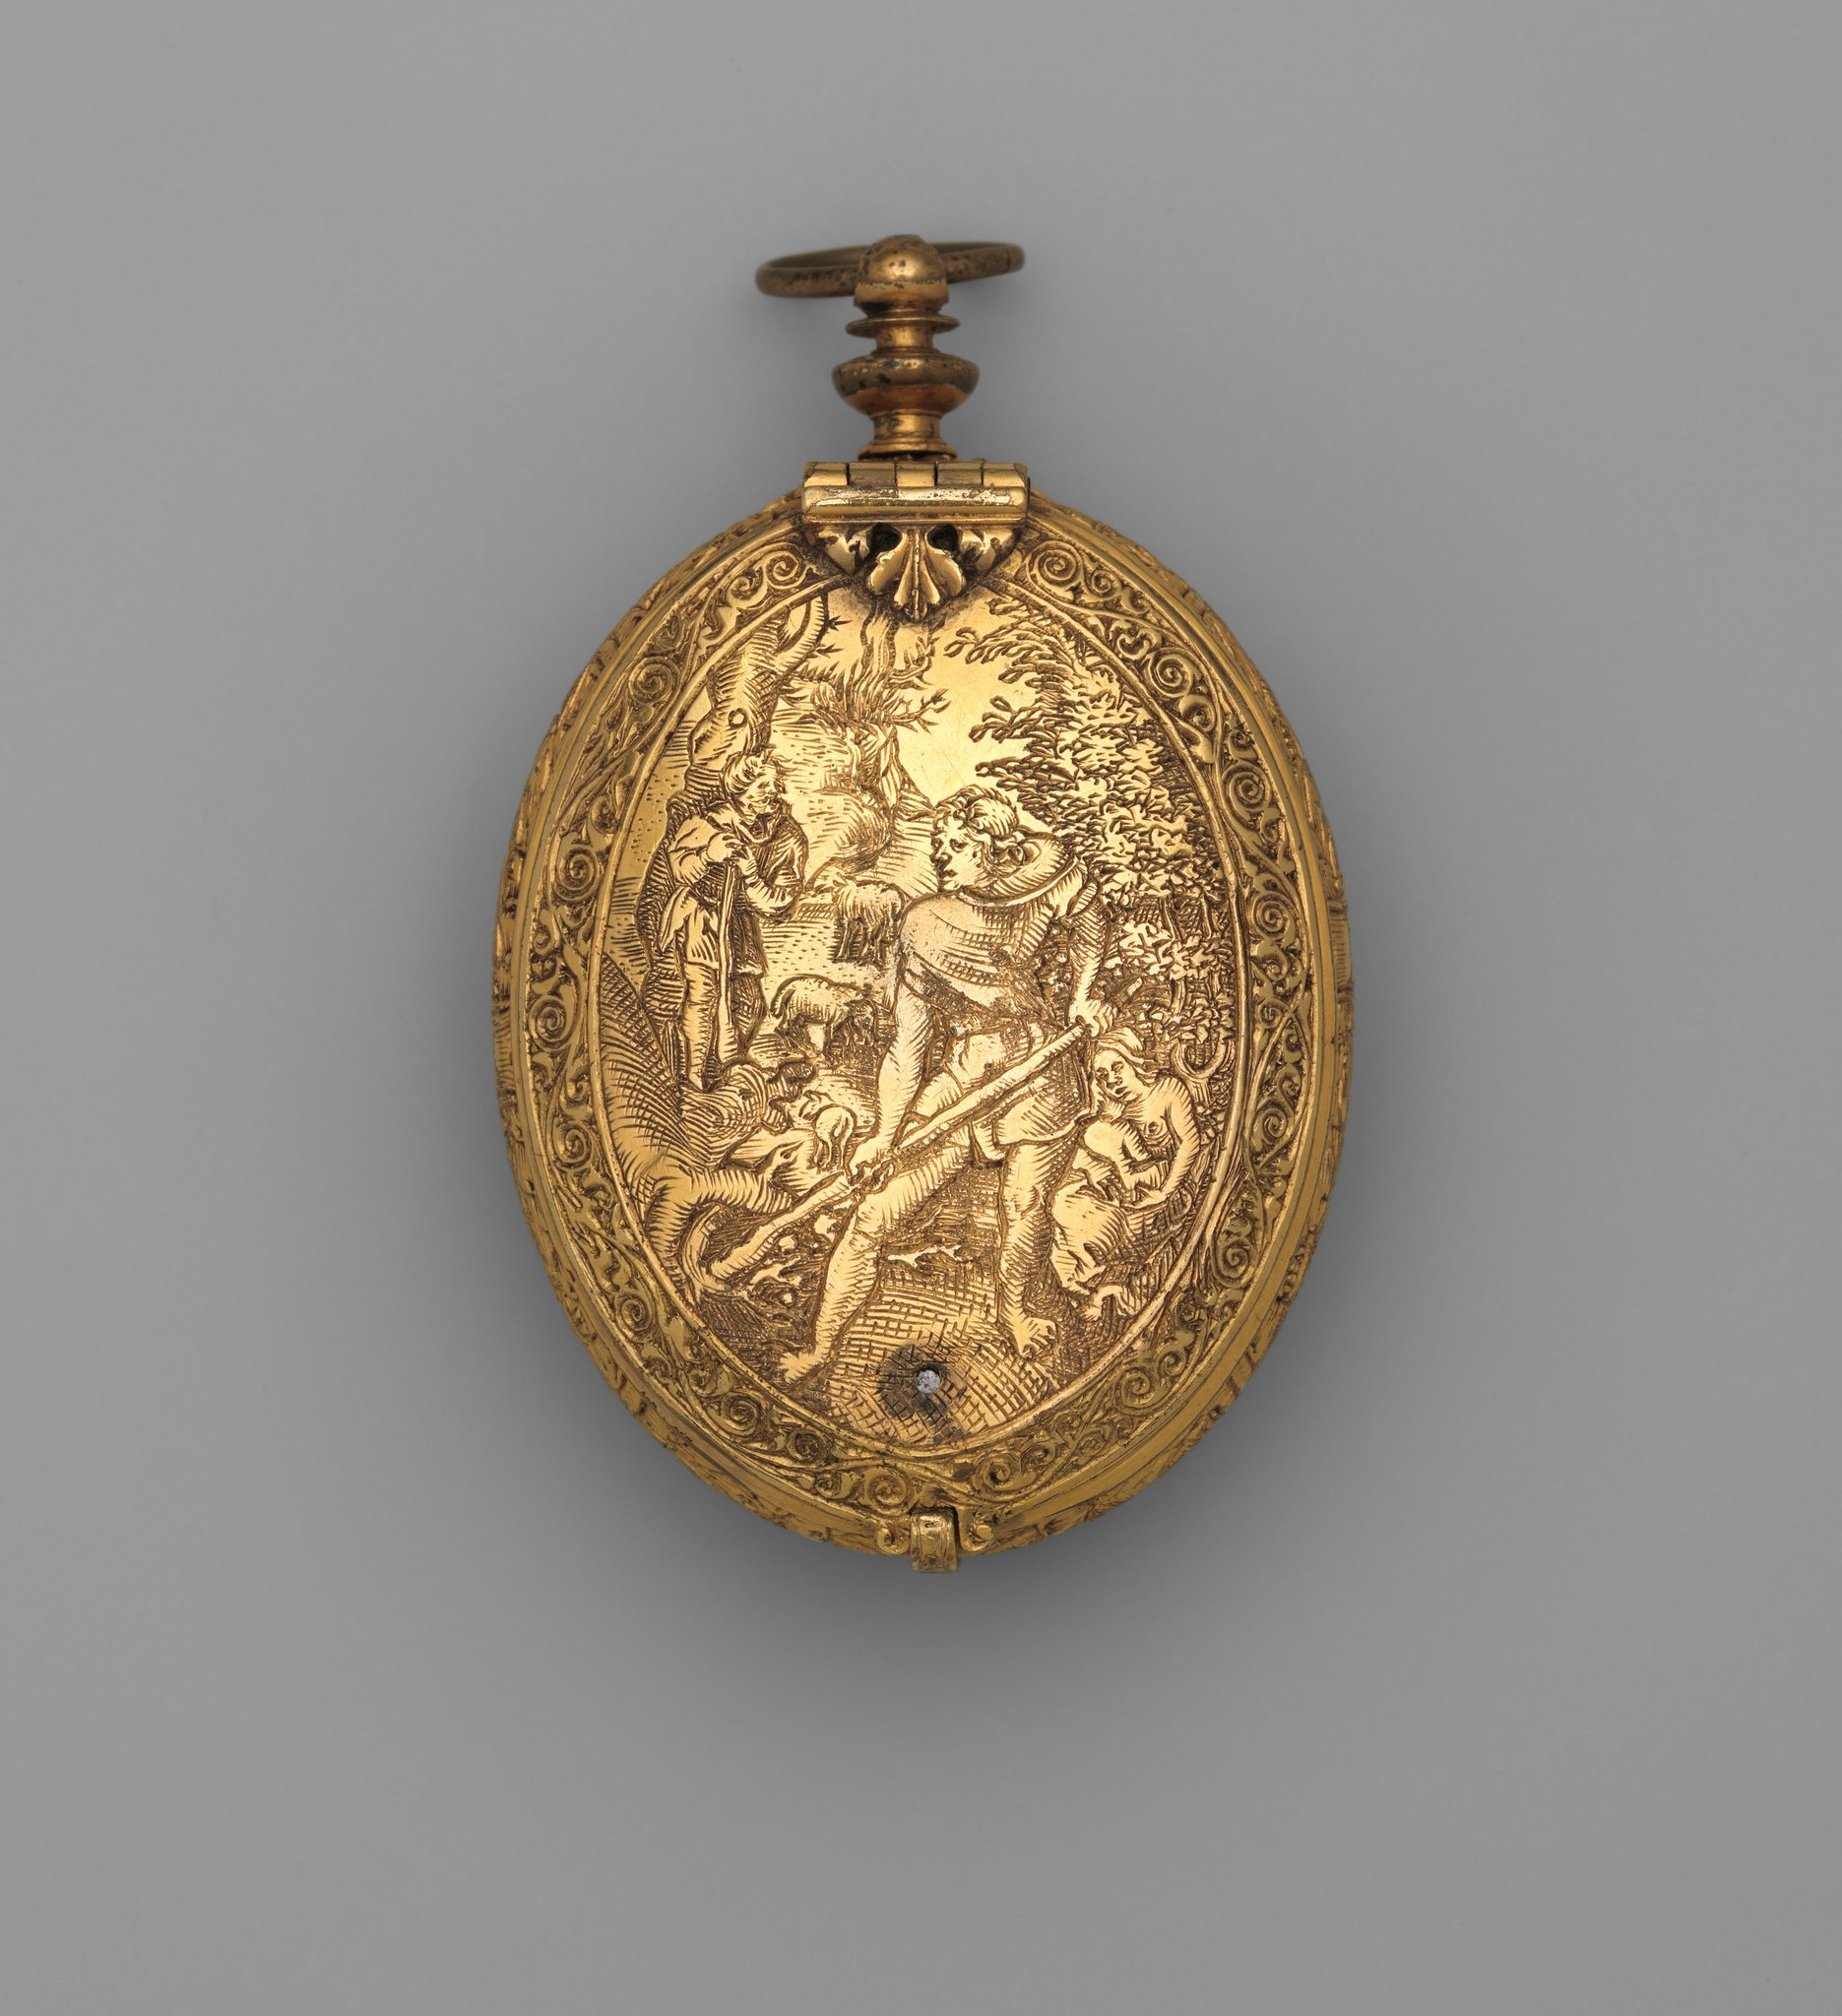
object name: watch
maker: w.a.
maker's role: maker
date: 1571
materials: gilt brass, steel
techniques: polish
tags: animals,men,women,trees